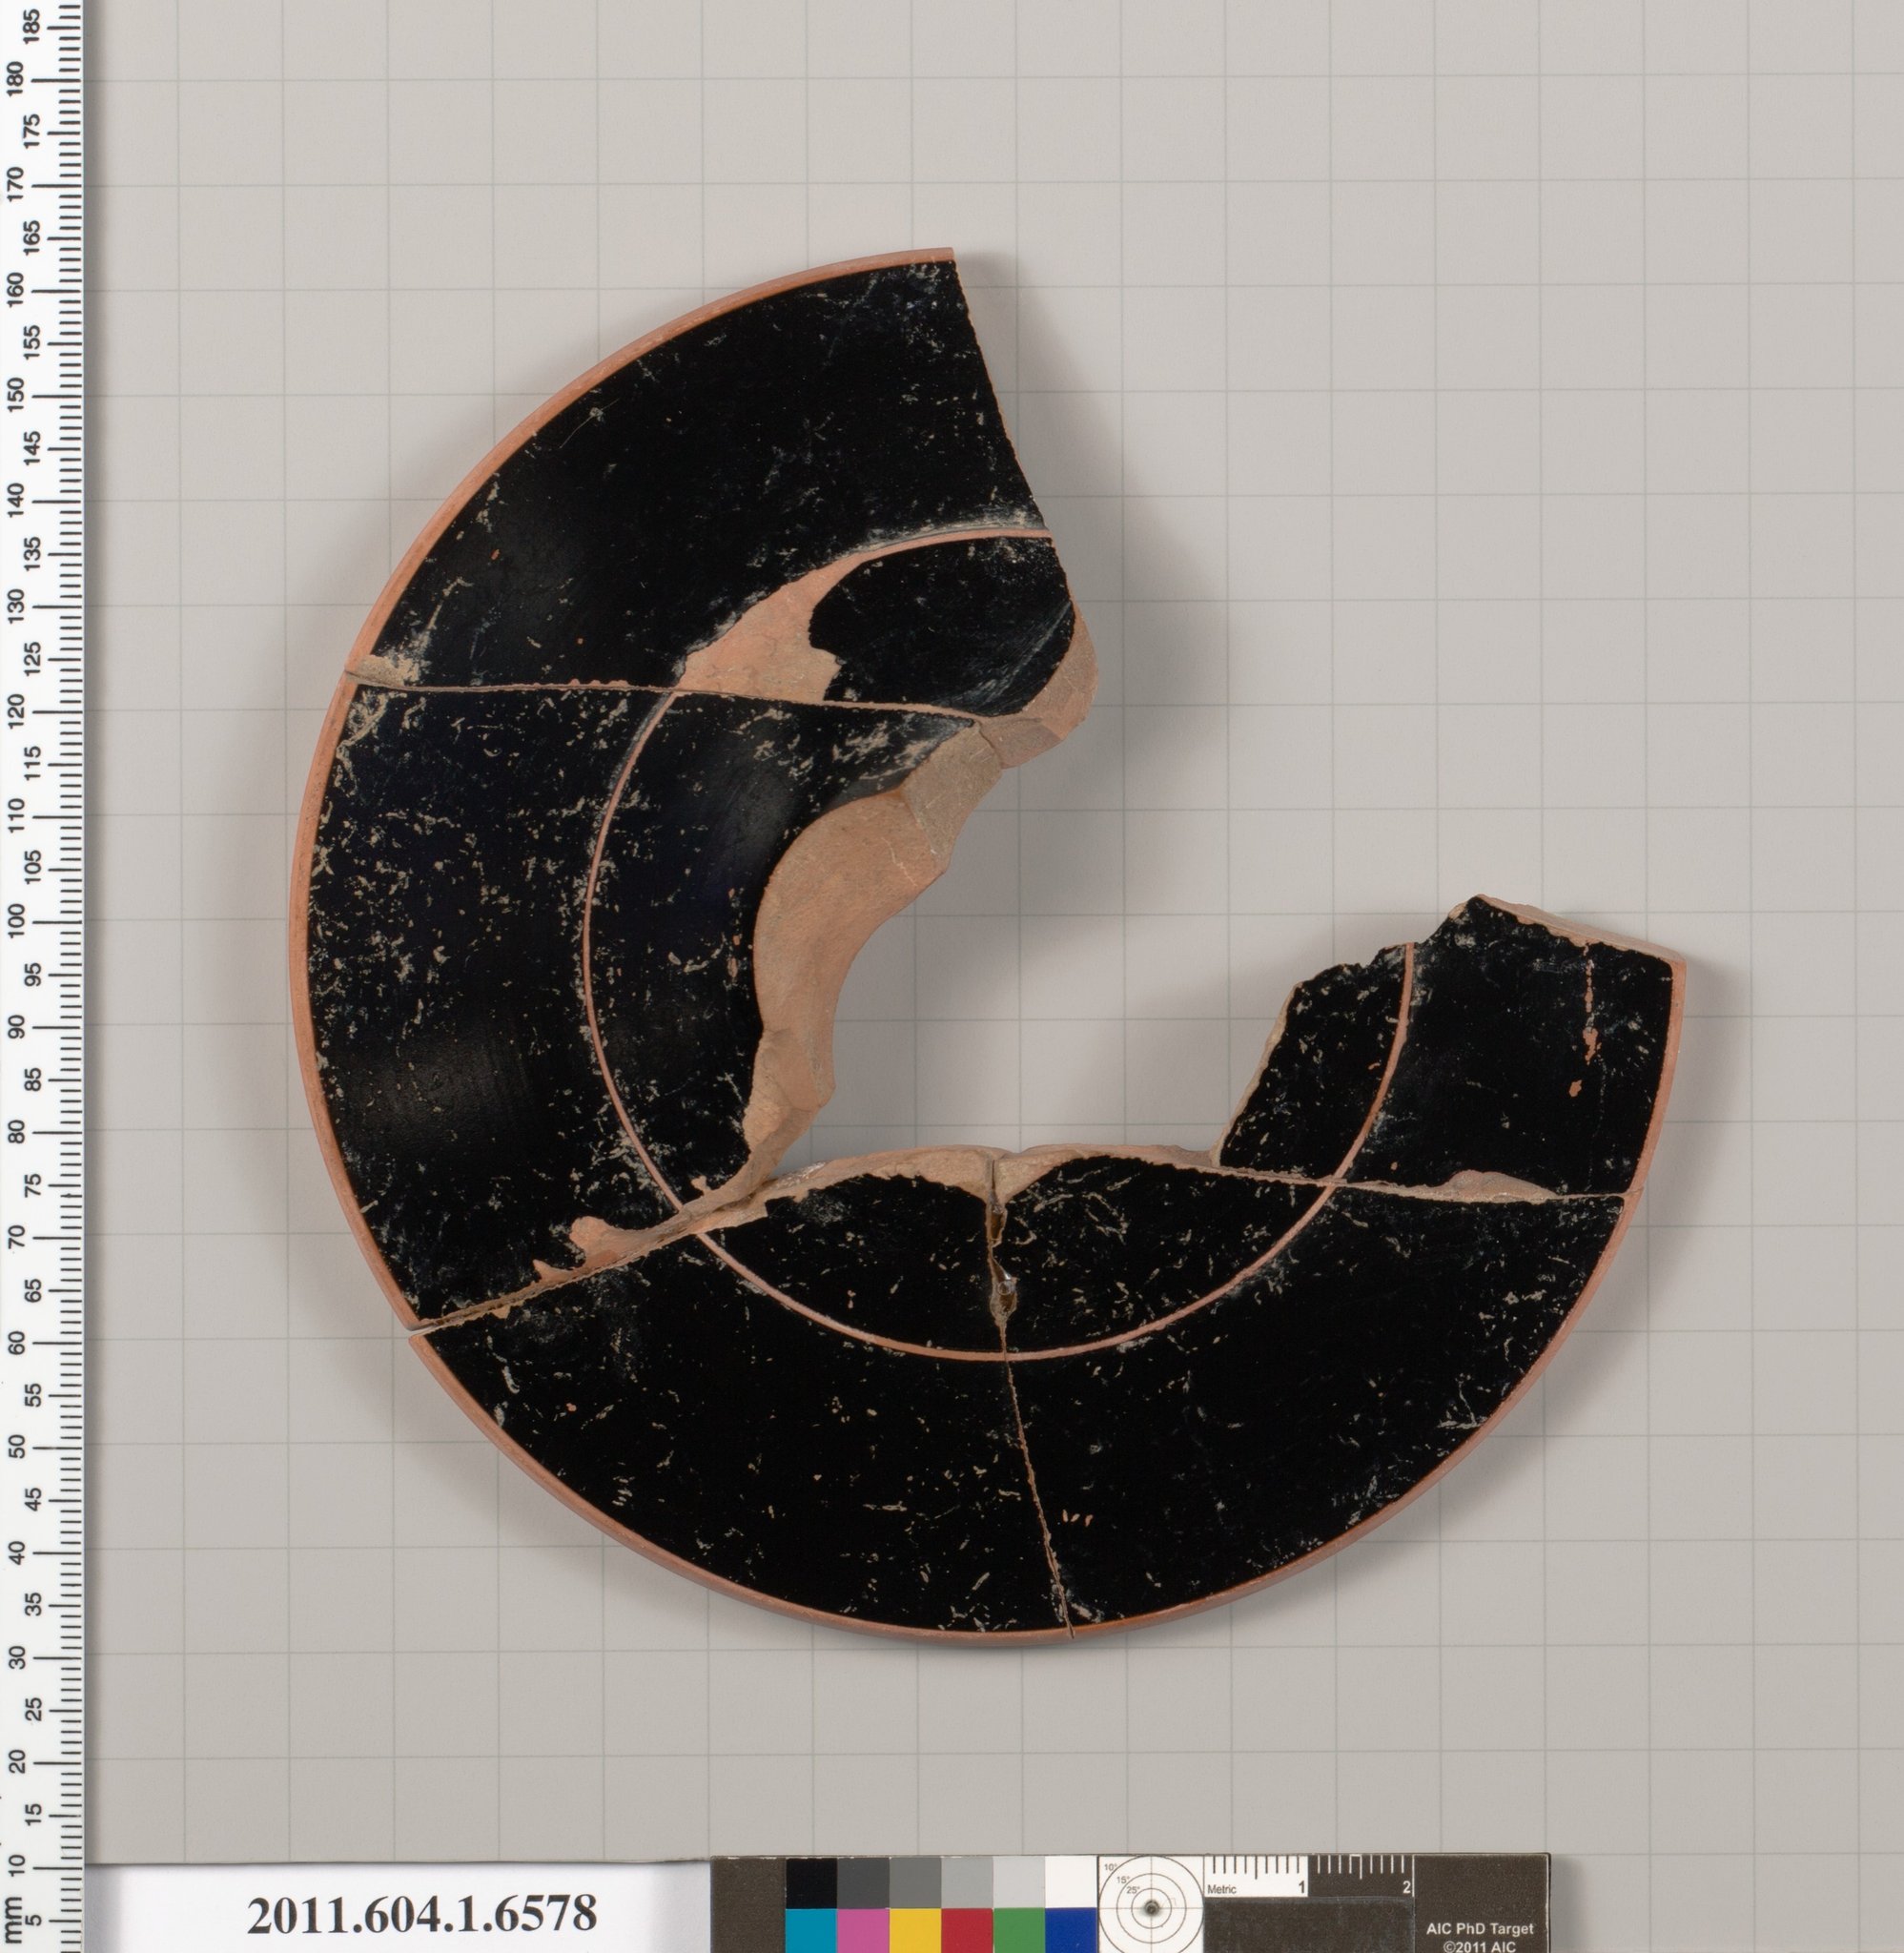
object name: kylix fragment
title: Terracotta fragment of a kylix (drinking cup)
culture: greek, attic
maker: colmar painter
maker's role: artist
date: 490-480 BCE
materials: terracotta